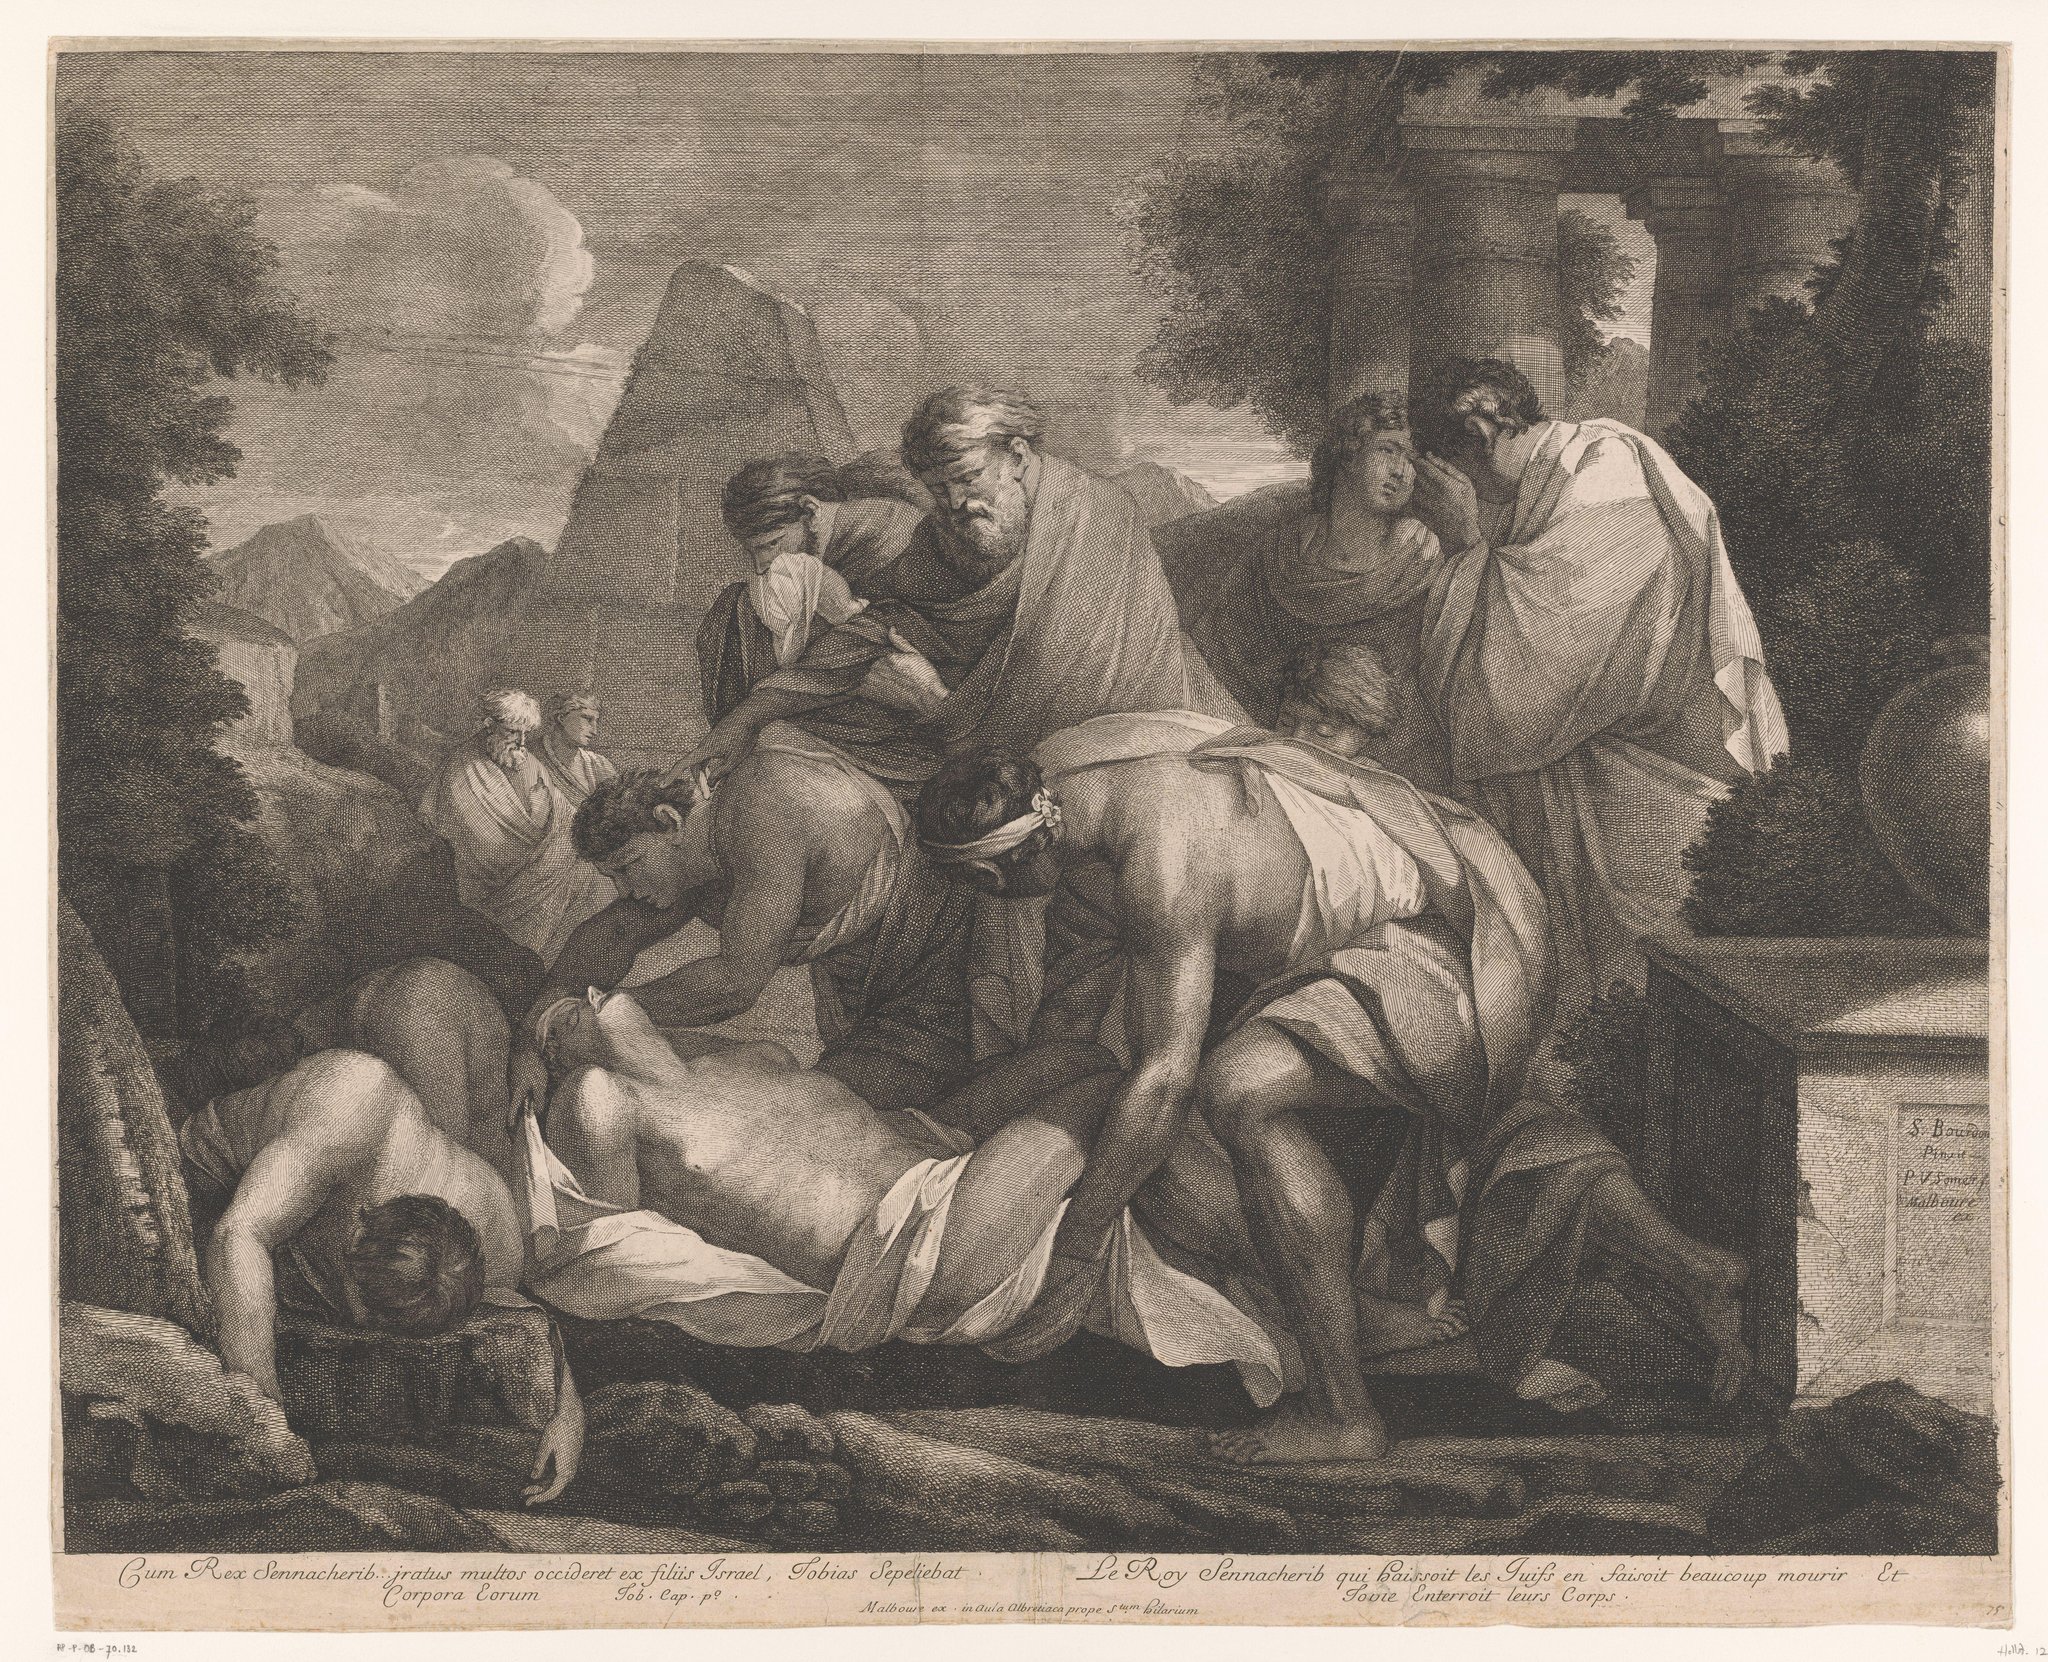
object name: print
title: Tobit begraaft de doden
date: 1680-1694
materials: paper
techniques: engraving, etching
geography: paris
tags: tobit buries a dead man at night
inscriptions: collector's mark: Lugt 240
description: Tobit begraaft de omgekomen joden in ballingschap in Assyrië.